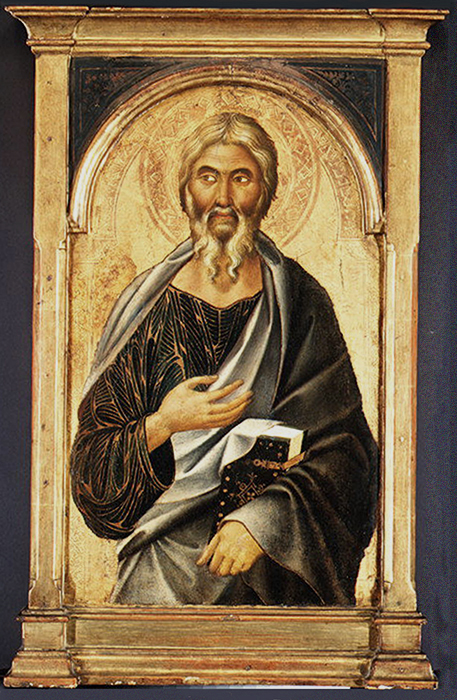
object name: painting, part of a polyptych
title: Saint John the Evangelist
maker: segna di buonaventura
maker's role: artist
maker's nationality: italian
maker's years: 1298-1331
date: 1320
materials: gold leaf, paint, wood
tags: men,saint john the evangelist